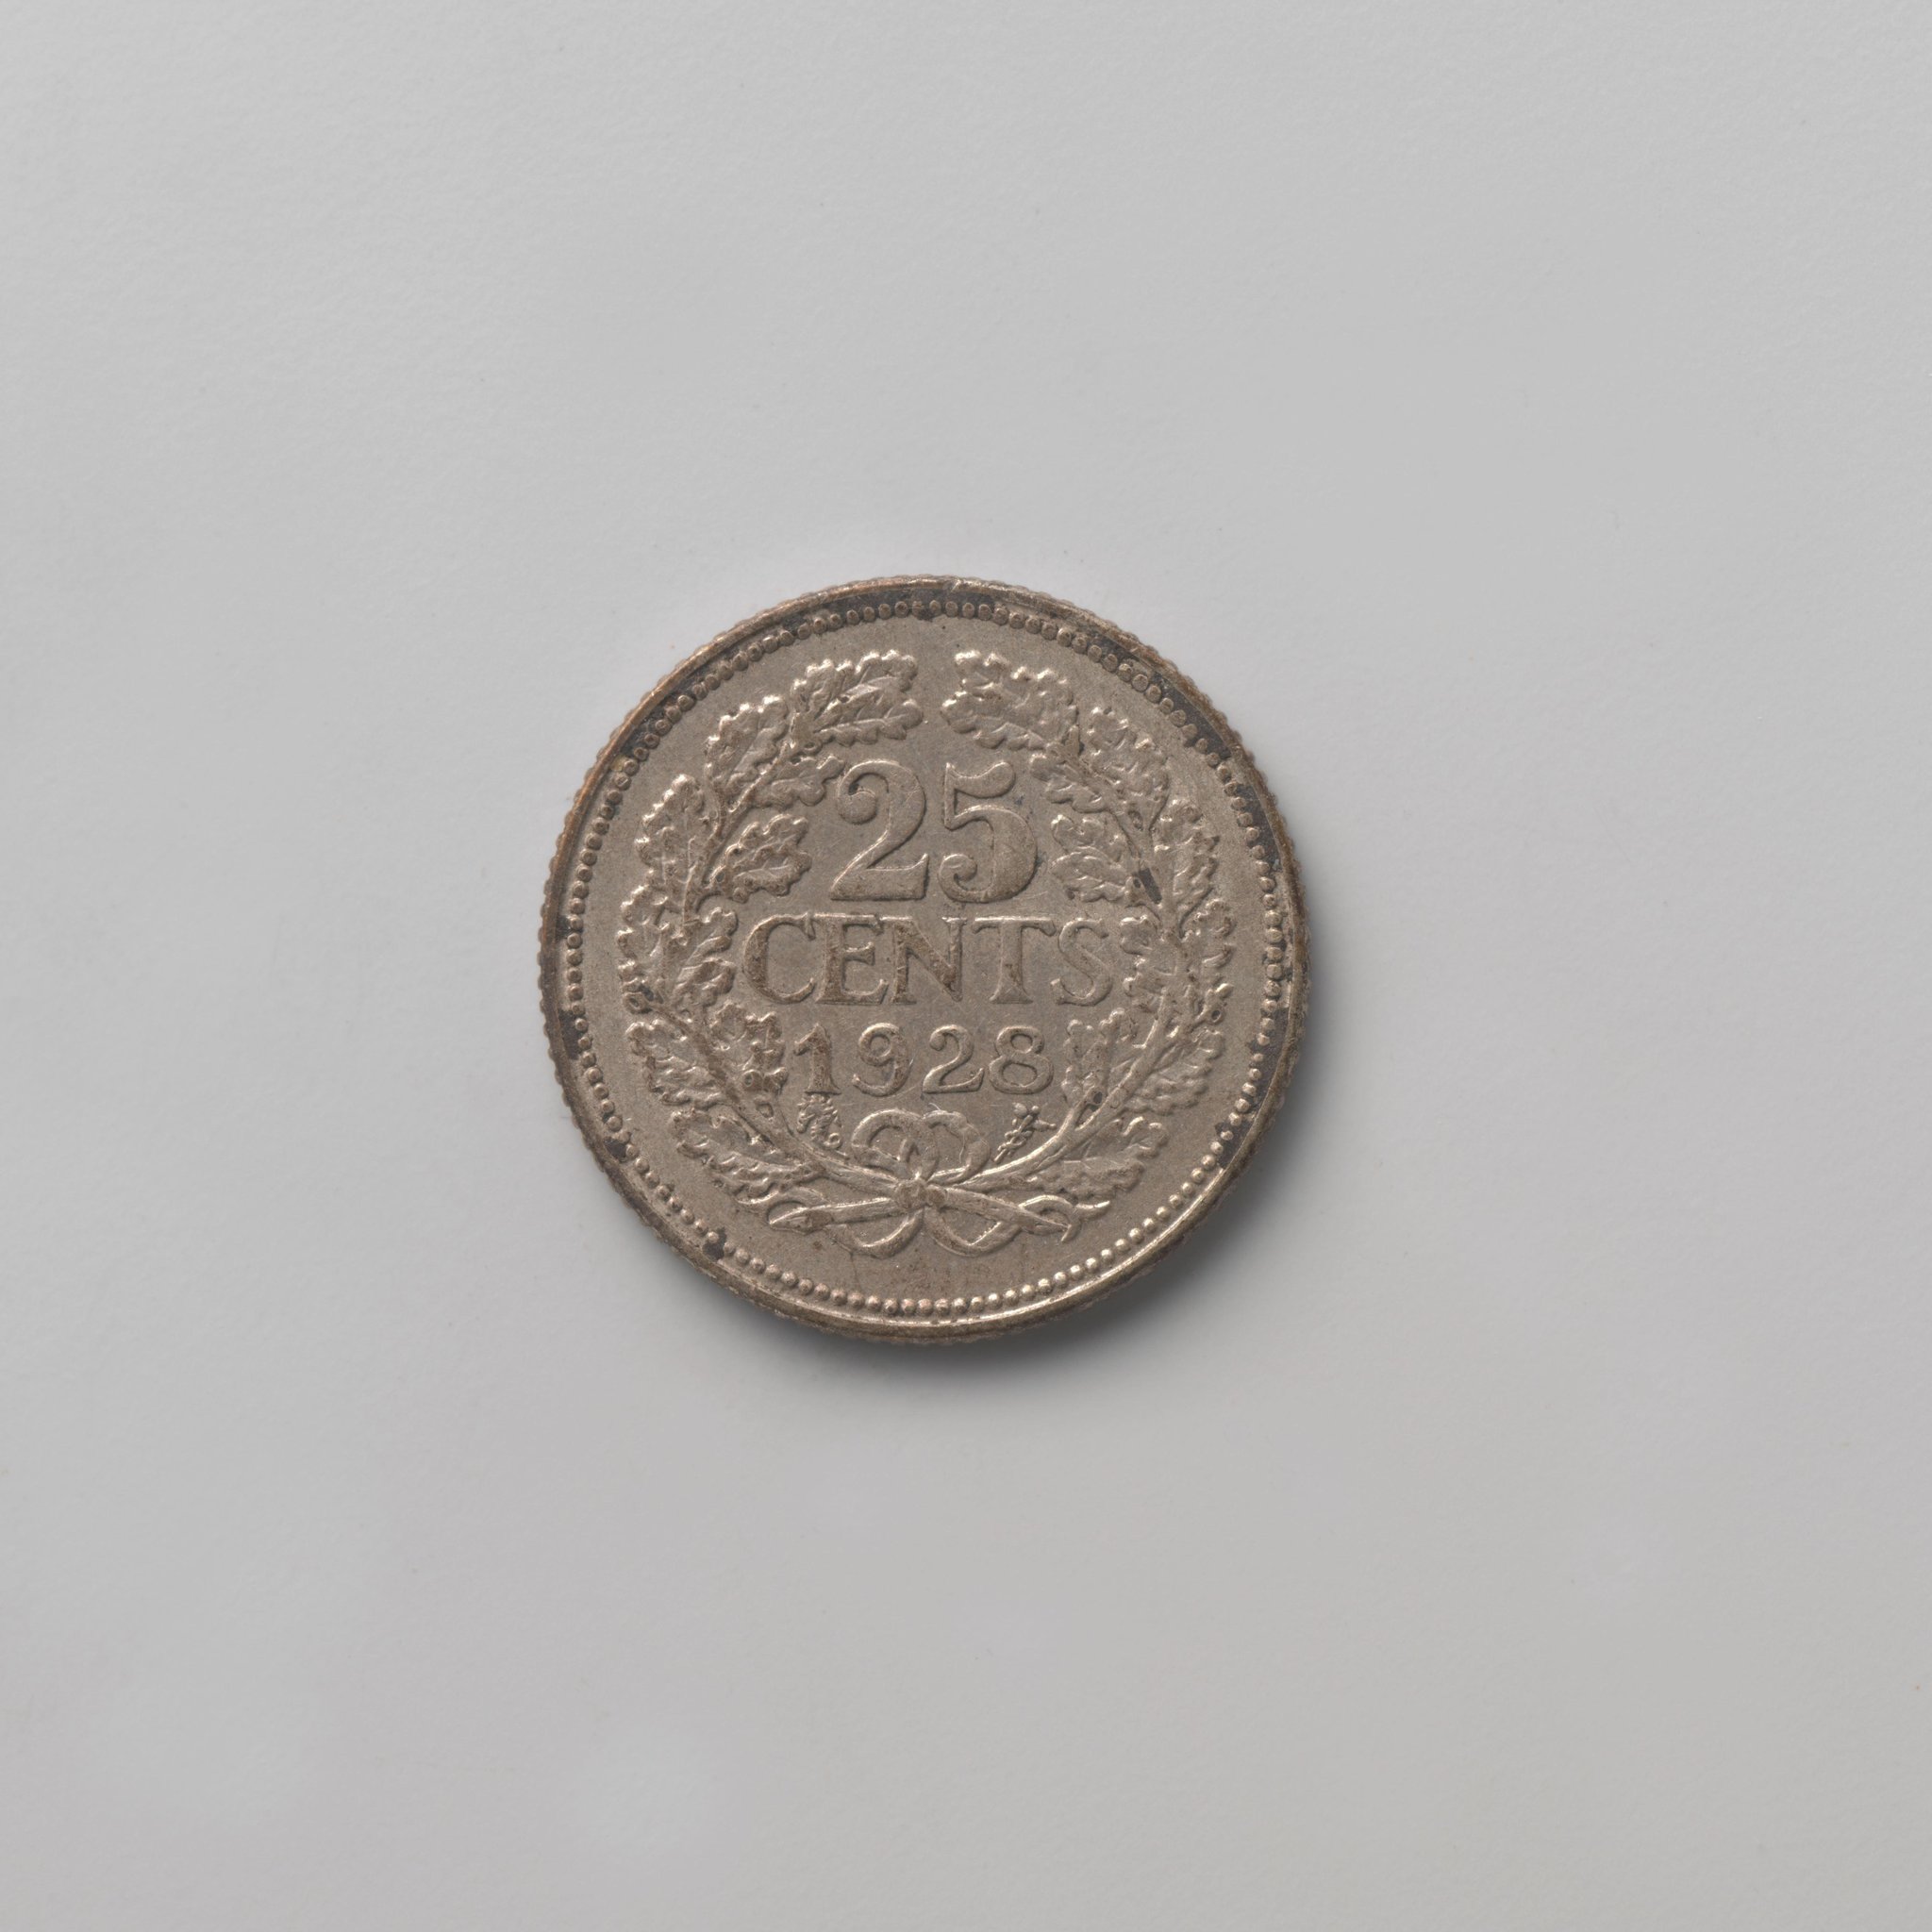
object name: coin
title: Nederlandse 25 cent,1928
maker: wilhelmina of the netherlands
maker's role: print maker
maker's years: 1880-1962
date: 1928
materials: silver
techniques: striking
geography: utrecht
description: Zilveren munt. Voorzijde: hoofd naar links. Keerzijde: binnen twee samengebonden eiketakken waarde-aanduiding 25 cents en jaartal. Kartelrand.